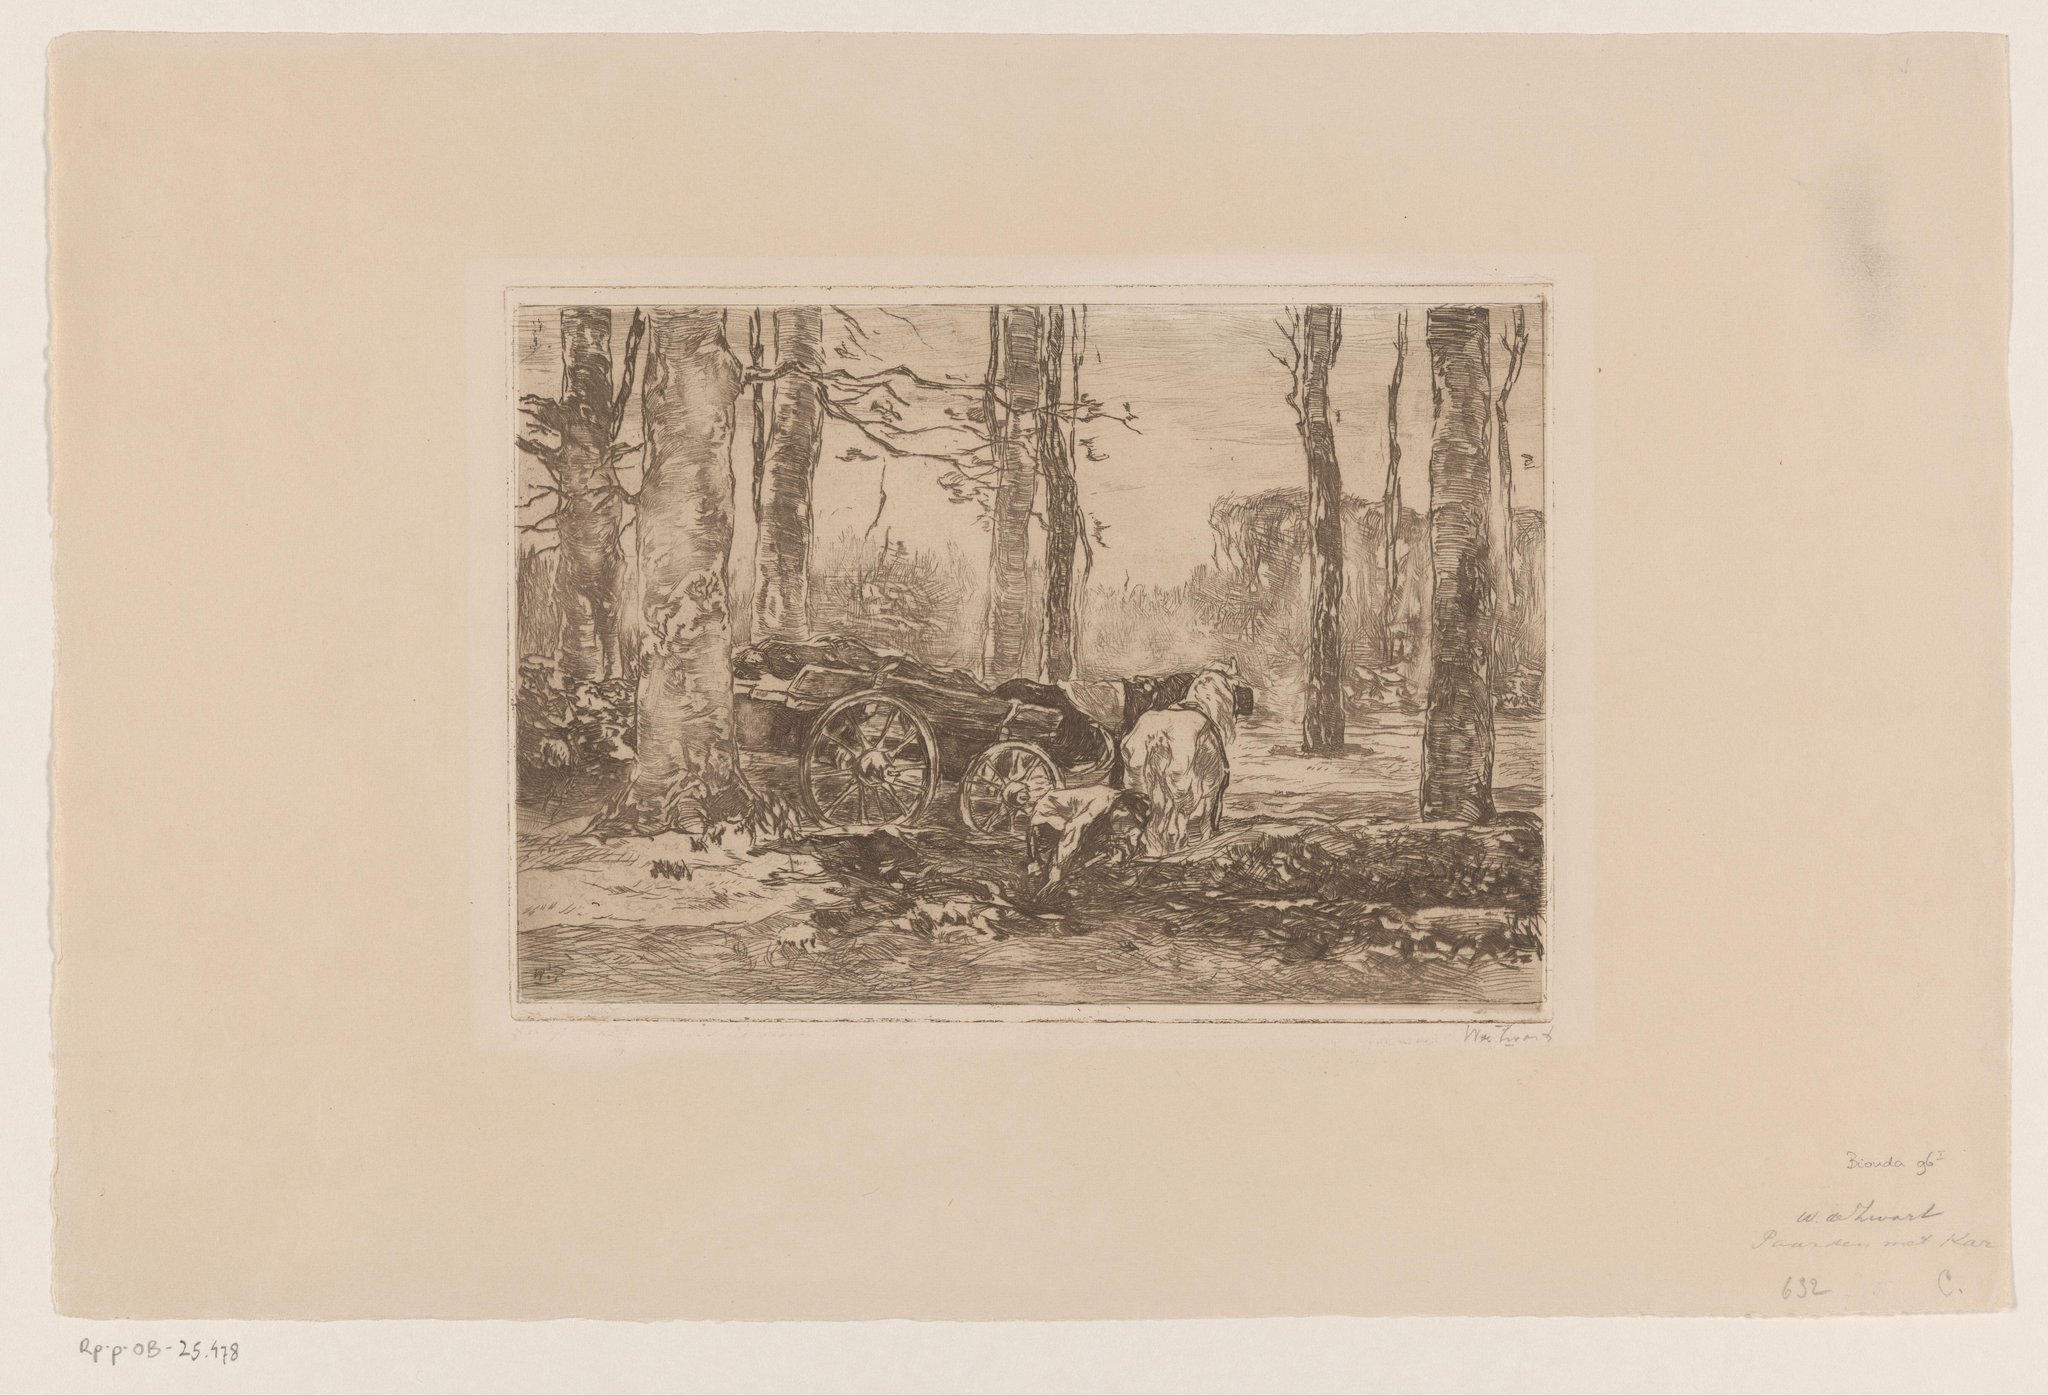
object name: print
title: Hakhout laden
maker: willem de zwart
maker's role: draughtsman, painter, print maker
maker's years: 1862-1931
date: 1898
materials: paper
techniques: etching, intaglio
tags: forester, (farm) wagon, freight wagon, cart